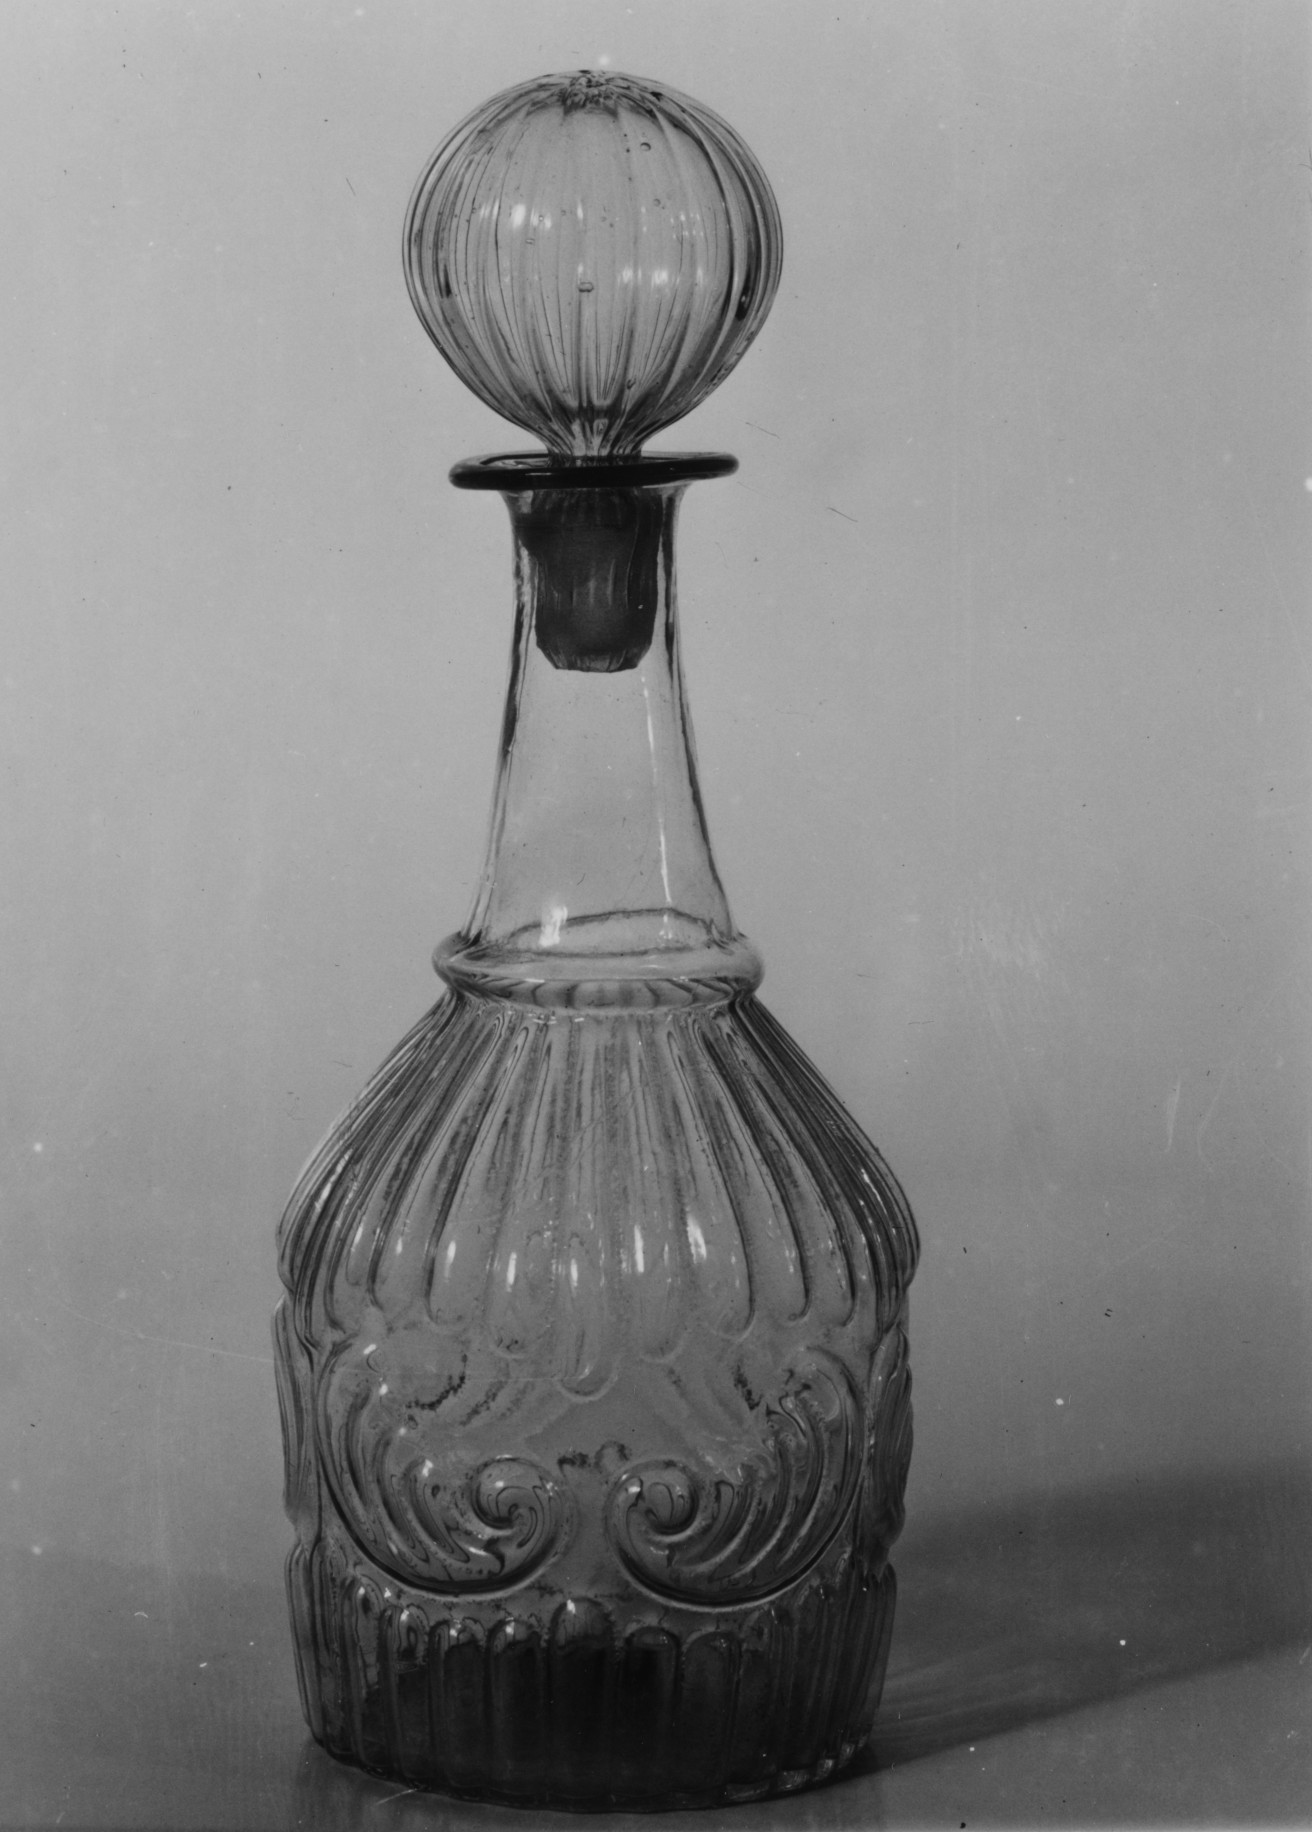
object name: decanter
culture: american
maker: new england glass company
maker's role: maker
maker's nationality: american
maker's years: 1818-1888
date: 1820-1840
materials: glass, lead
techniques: glassblowing, molding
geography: united states